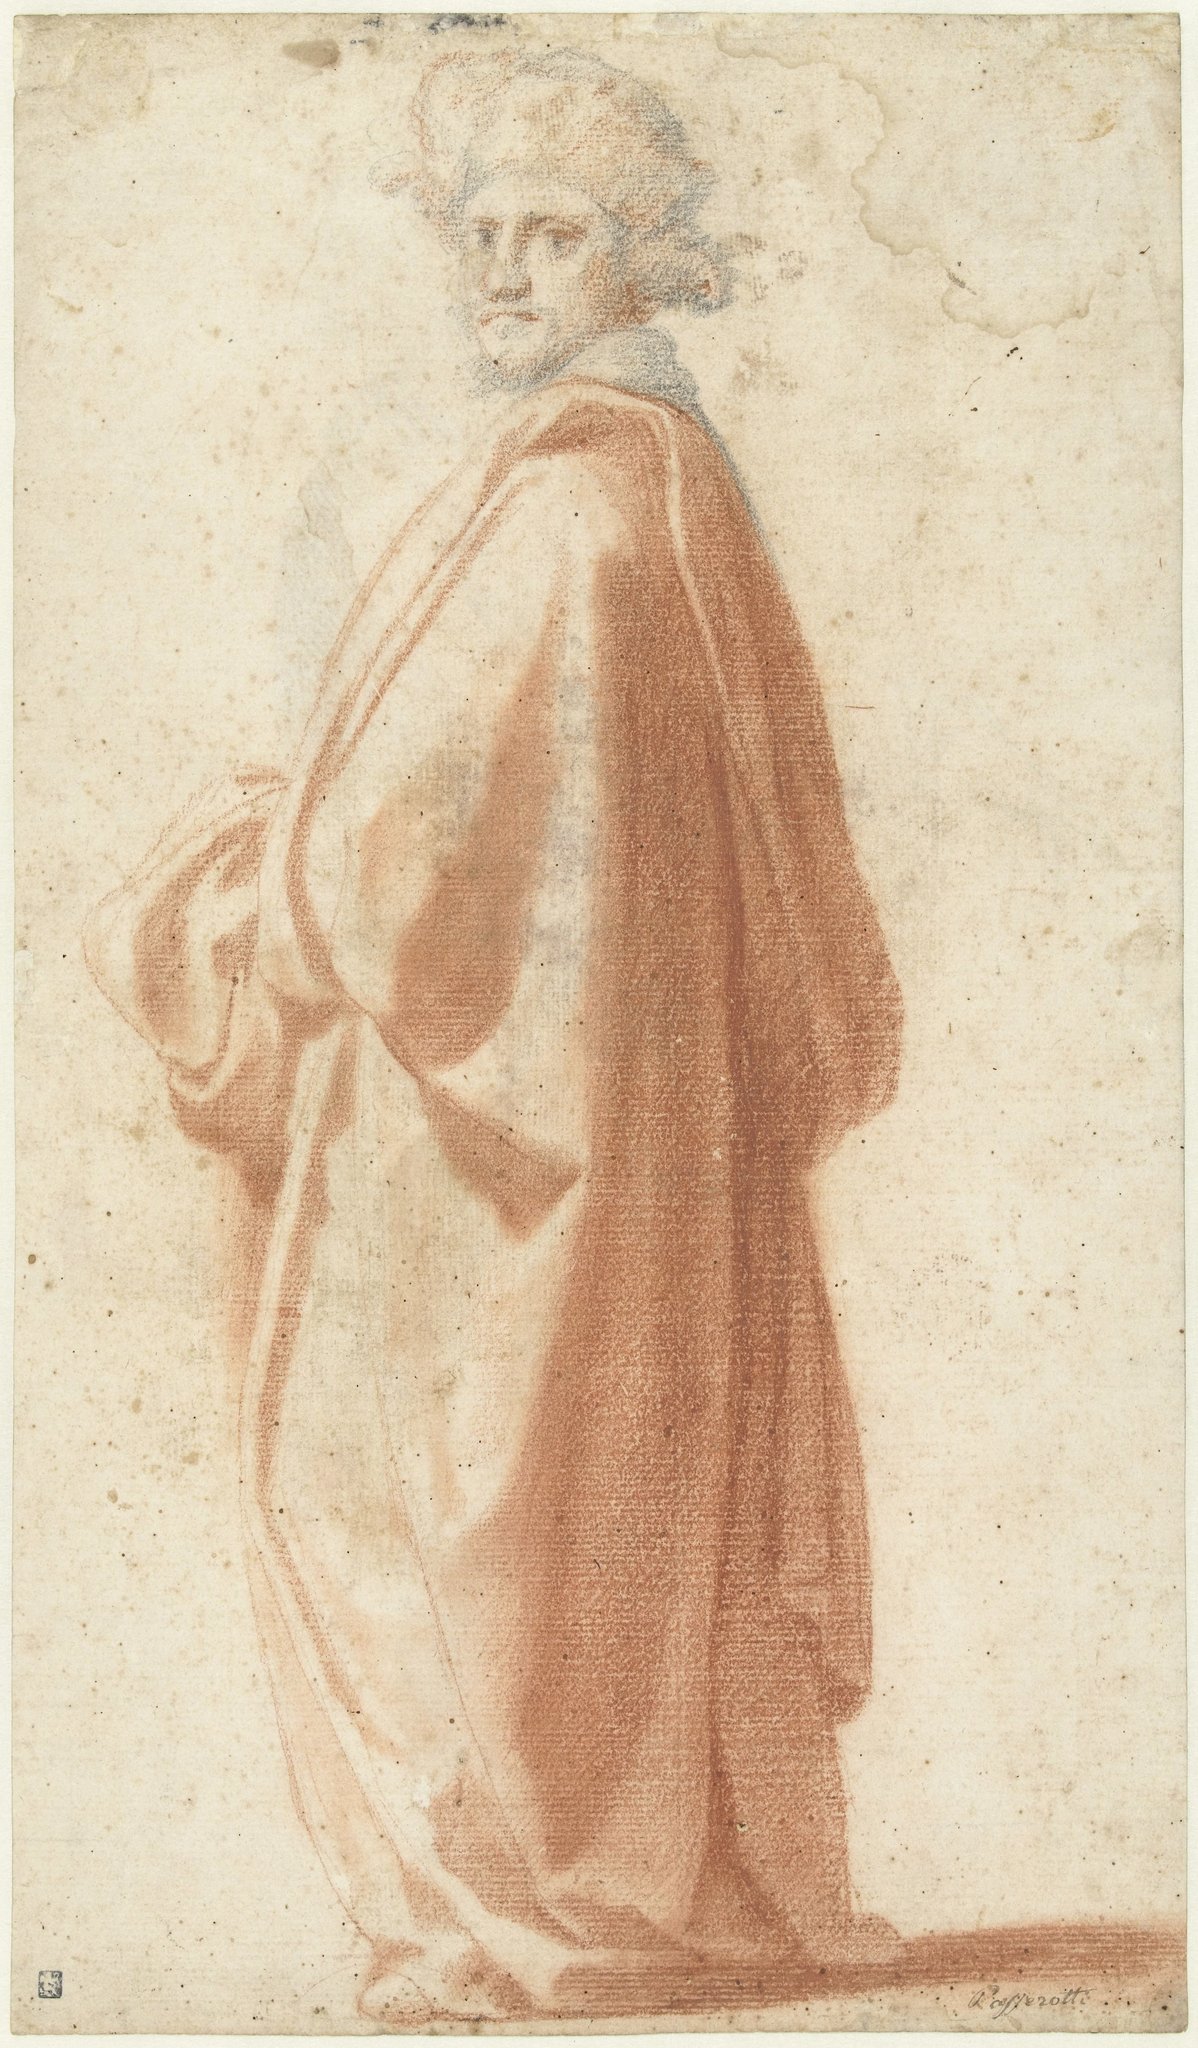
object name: drawing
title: Studie naar een model in wijde mantel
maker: matteo rosselli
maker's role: draughtsman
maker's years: 1578-1651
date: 1590-1610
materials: chalk, paper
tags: standing figure, drapery, draped garment, 'gewandgebung'